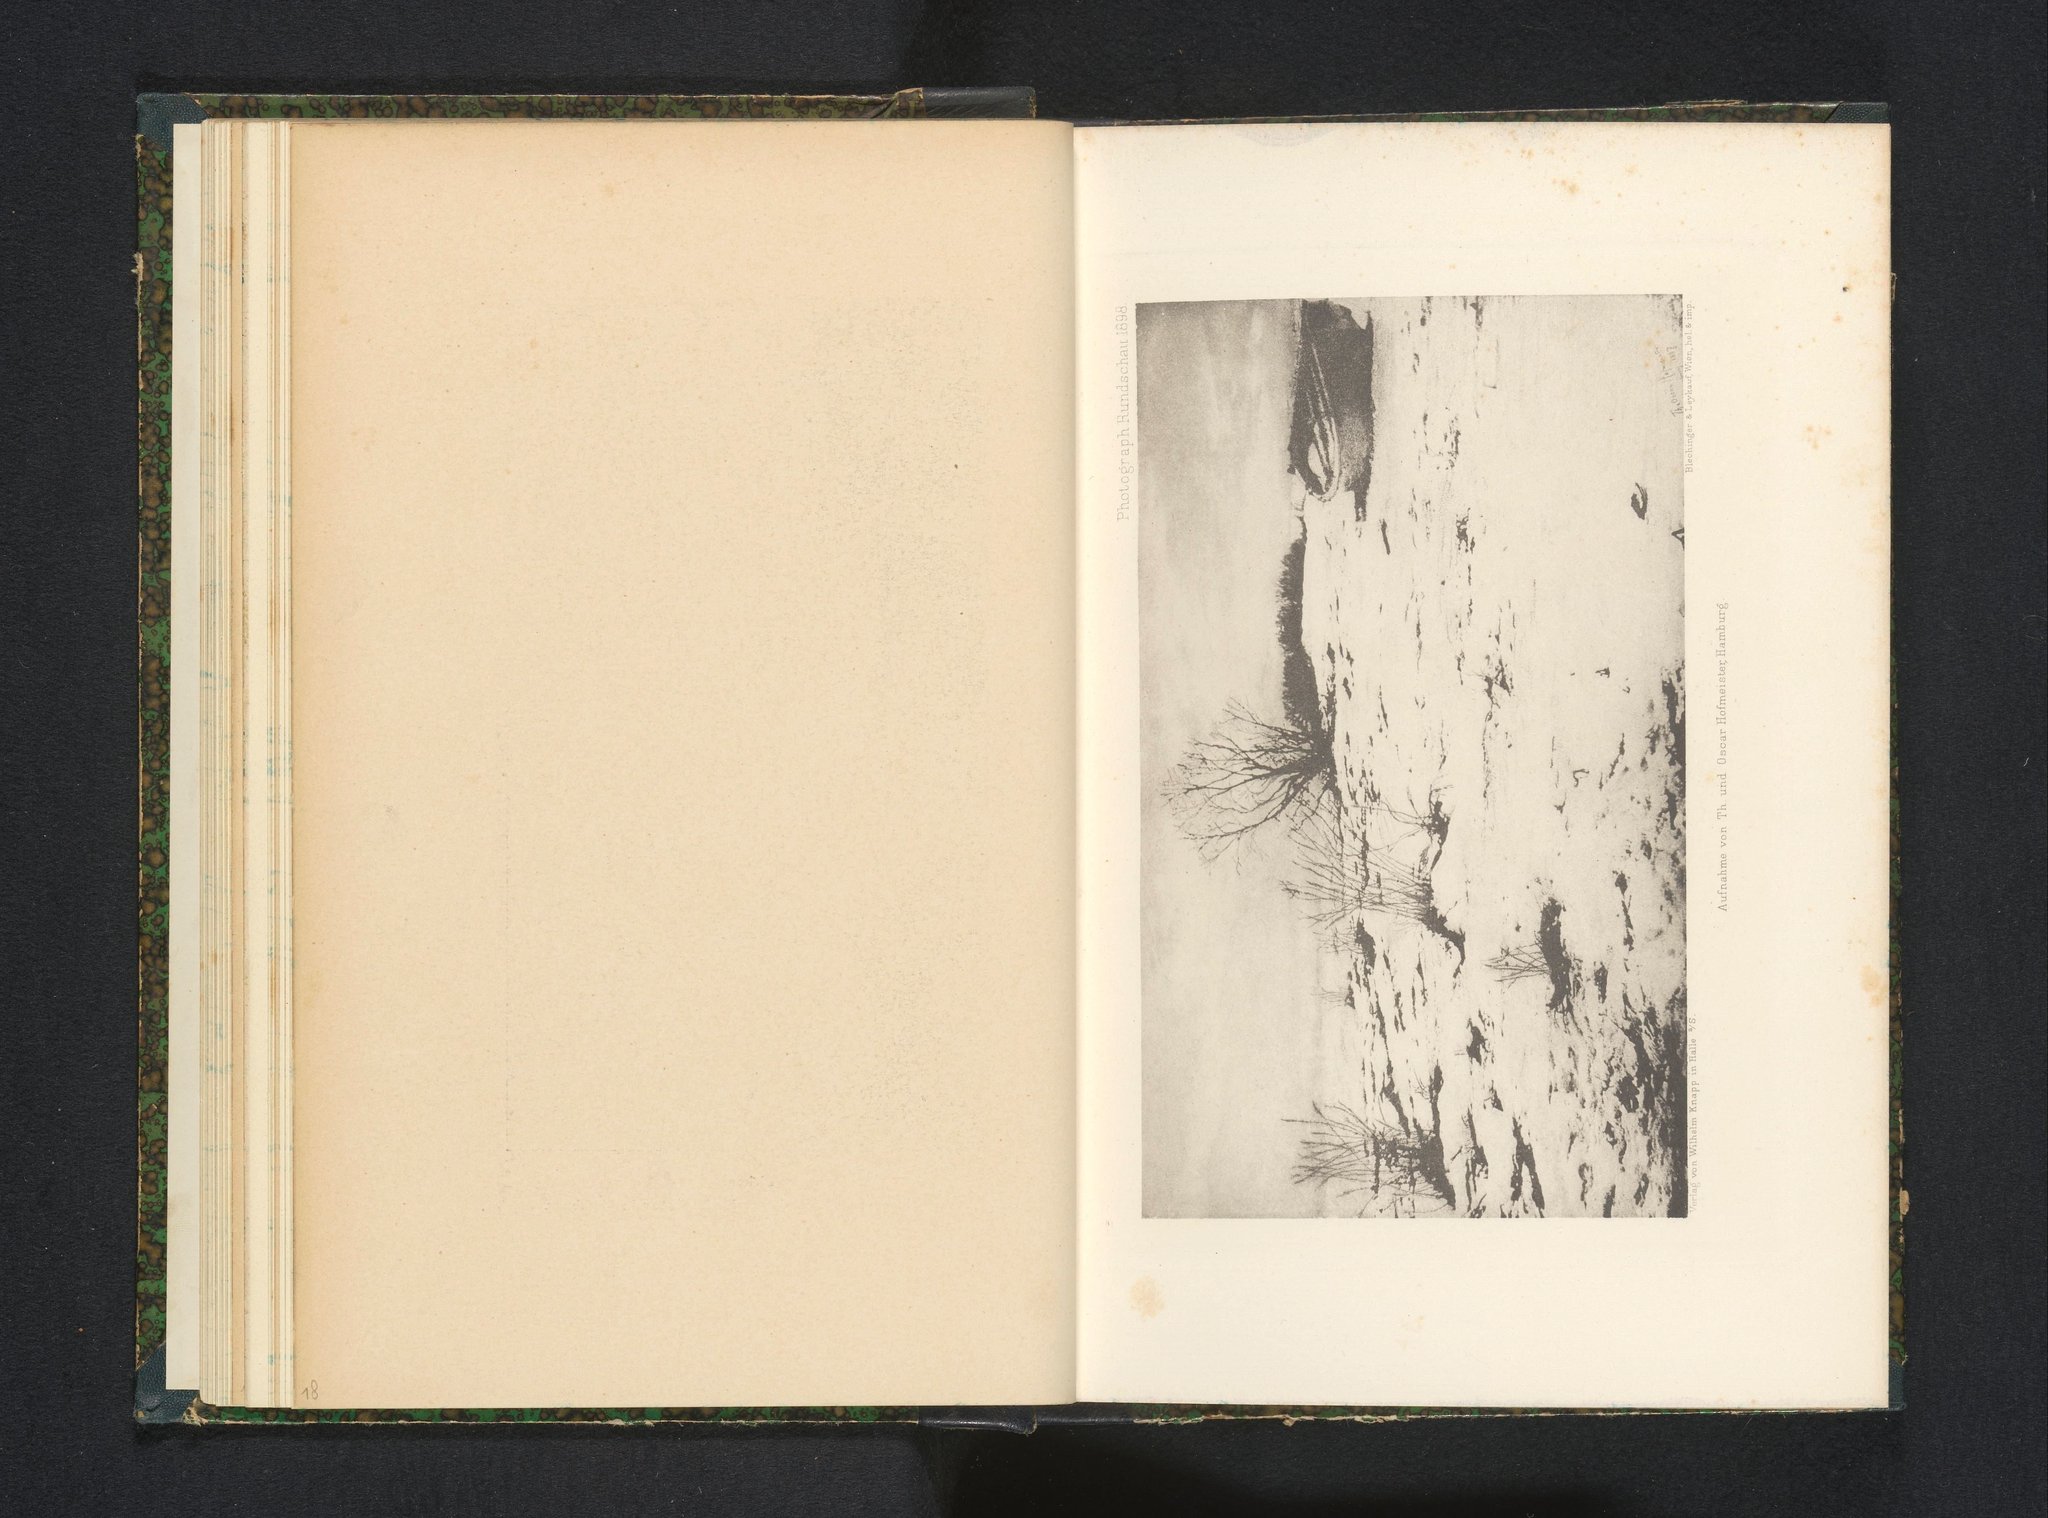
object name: page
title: Winters landschap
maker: th. u. o. hofmeister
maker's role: fotograaf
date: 1897-1899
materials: paper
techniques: photoaquatint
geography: vienna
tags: landscapes, snow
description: Prent op tweede ongenummerde pagina na pagina 32.